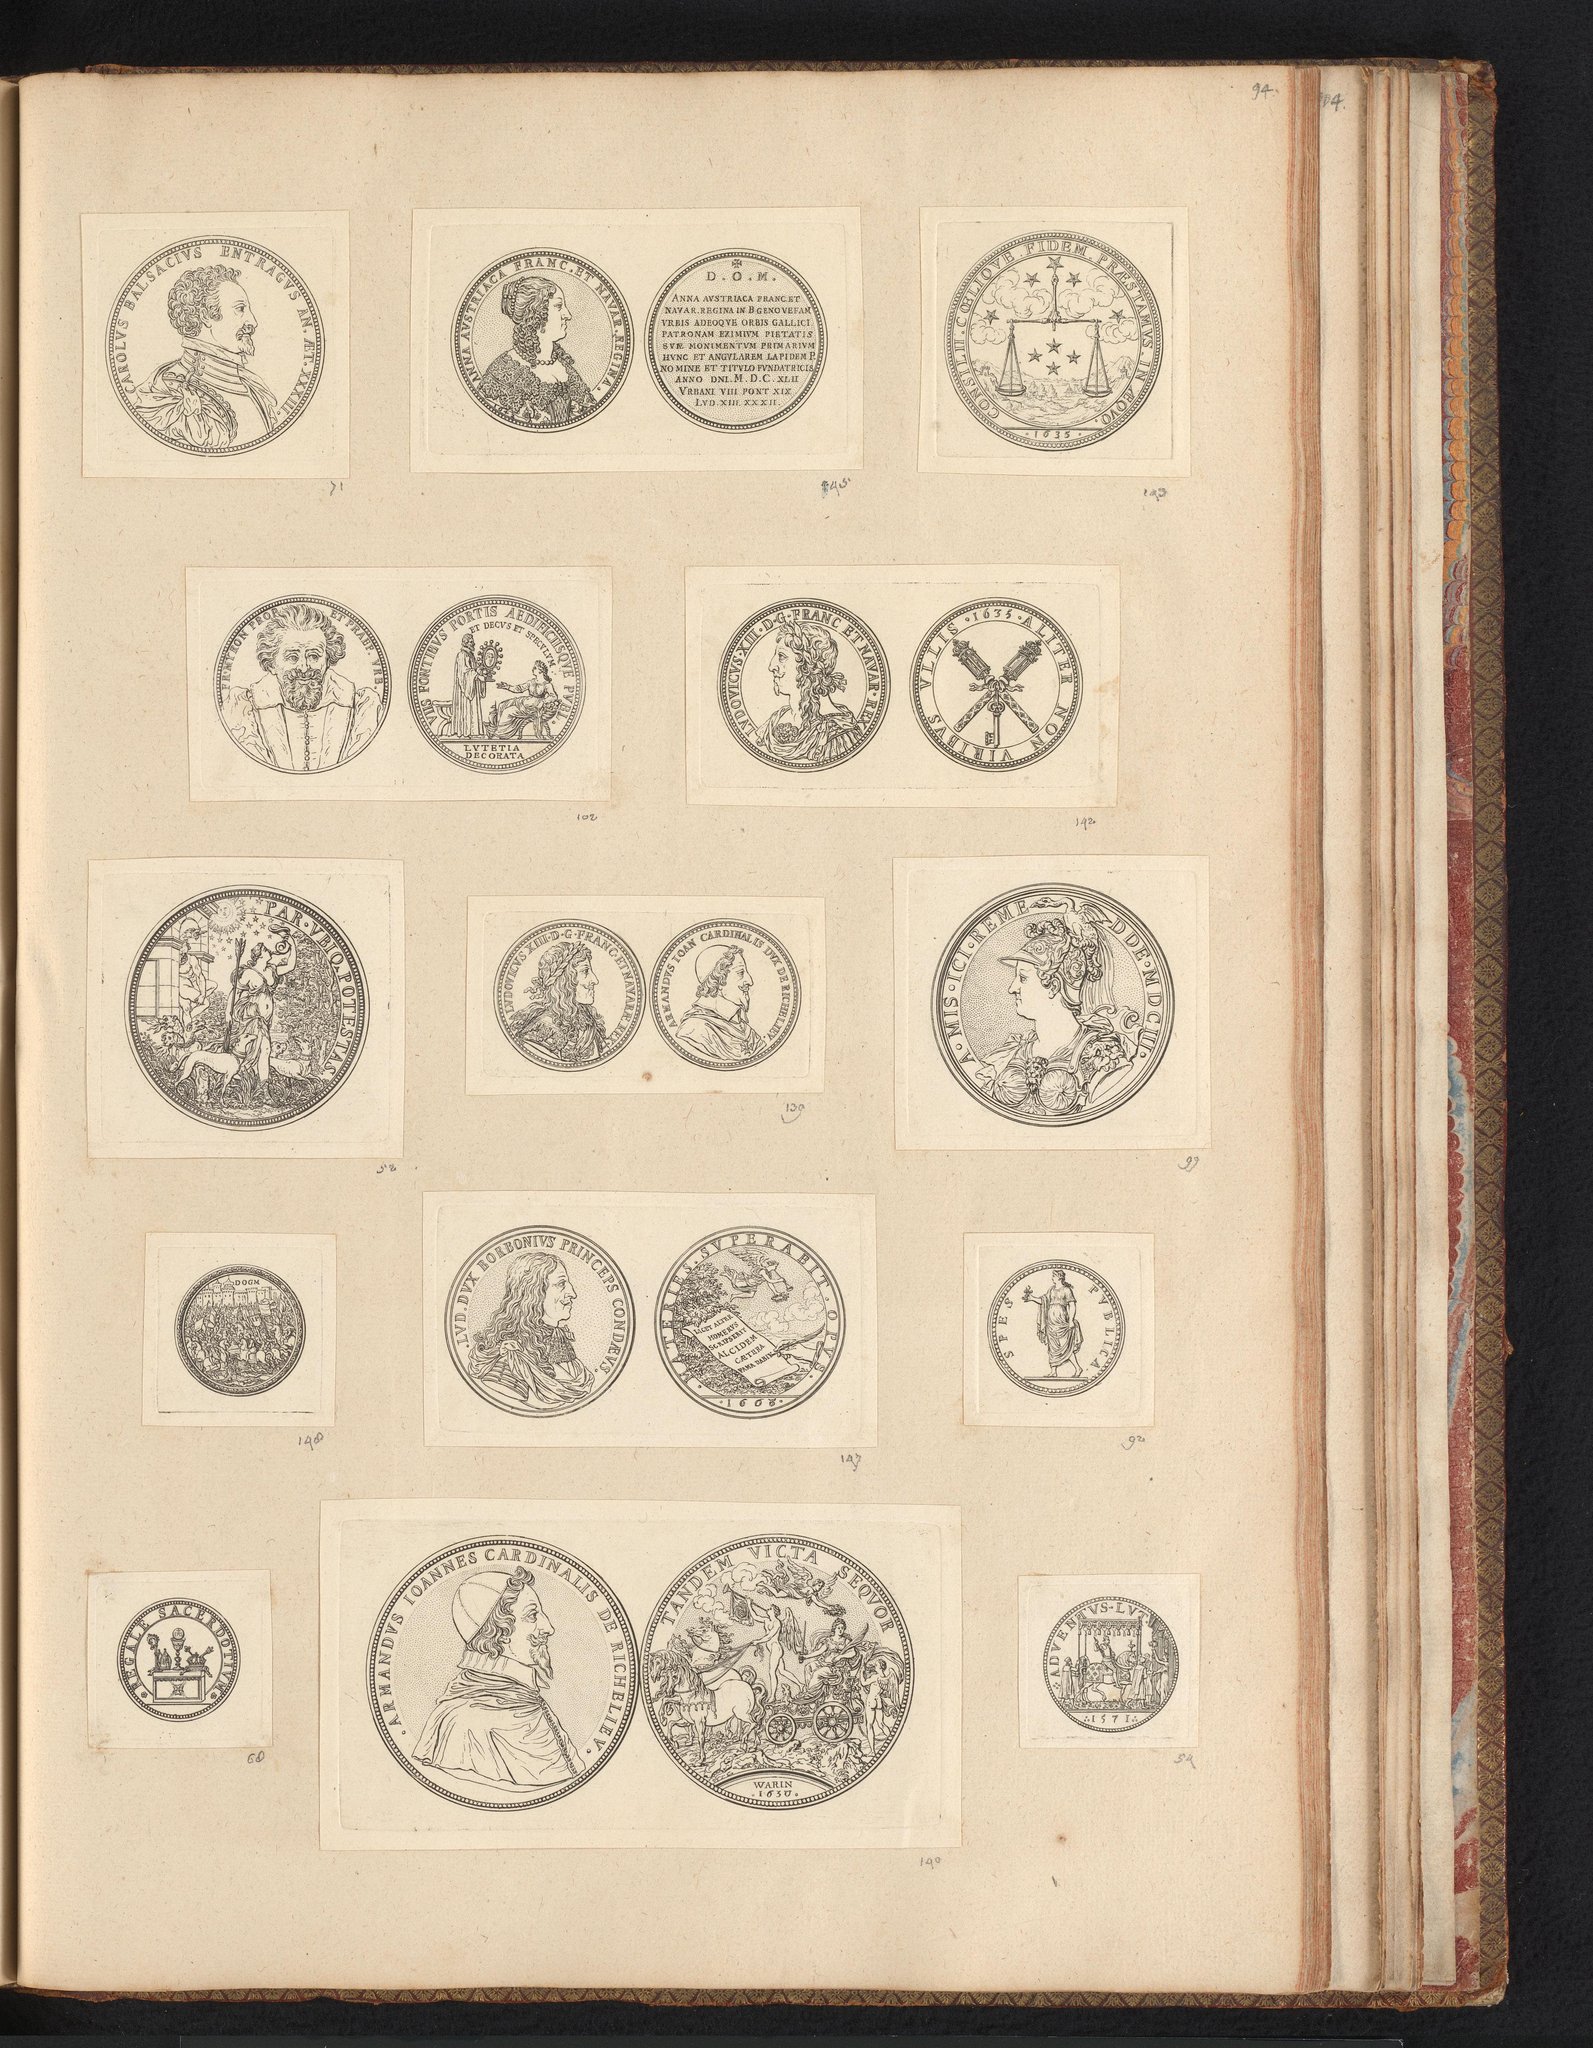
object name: album leaf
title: Medailles met de geschiedenis van Frankrijk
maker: sébastien leclerc (i)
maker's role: print maker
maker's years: 1637-1714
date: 1685-1688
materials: paper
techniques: etching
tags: anna van oostenrijk (koningin van frankrijk), cologne, maria de' medici, paris, armand-jean du plessis hertog van richelieu, lodewijk xiii (koning van frankrijk), diana hunting, (story of) minerva (pallas, athena), cardinal, historical persons, medal (considered as a piece of sculpture, regardless of its specific function), (story of) venus (aphrodite), ranks ~ rulers, sovereigns, bellona (enyo)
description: Veertien medailles met voorstellingen gerelateerd aan de geschiedenis van Frankrijk. Prenten maken deel uit van een album.